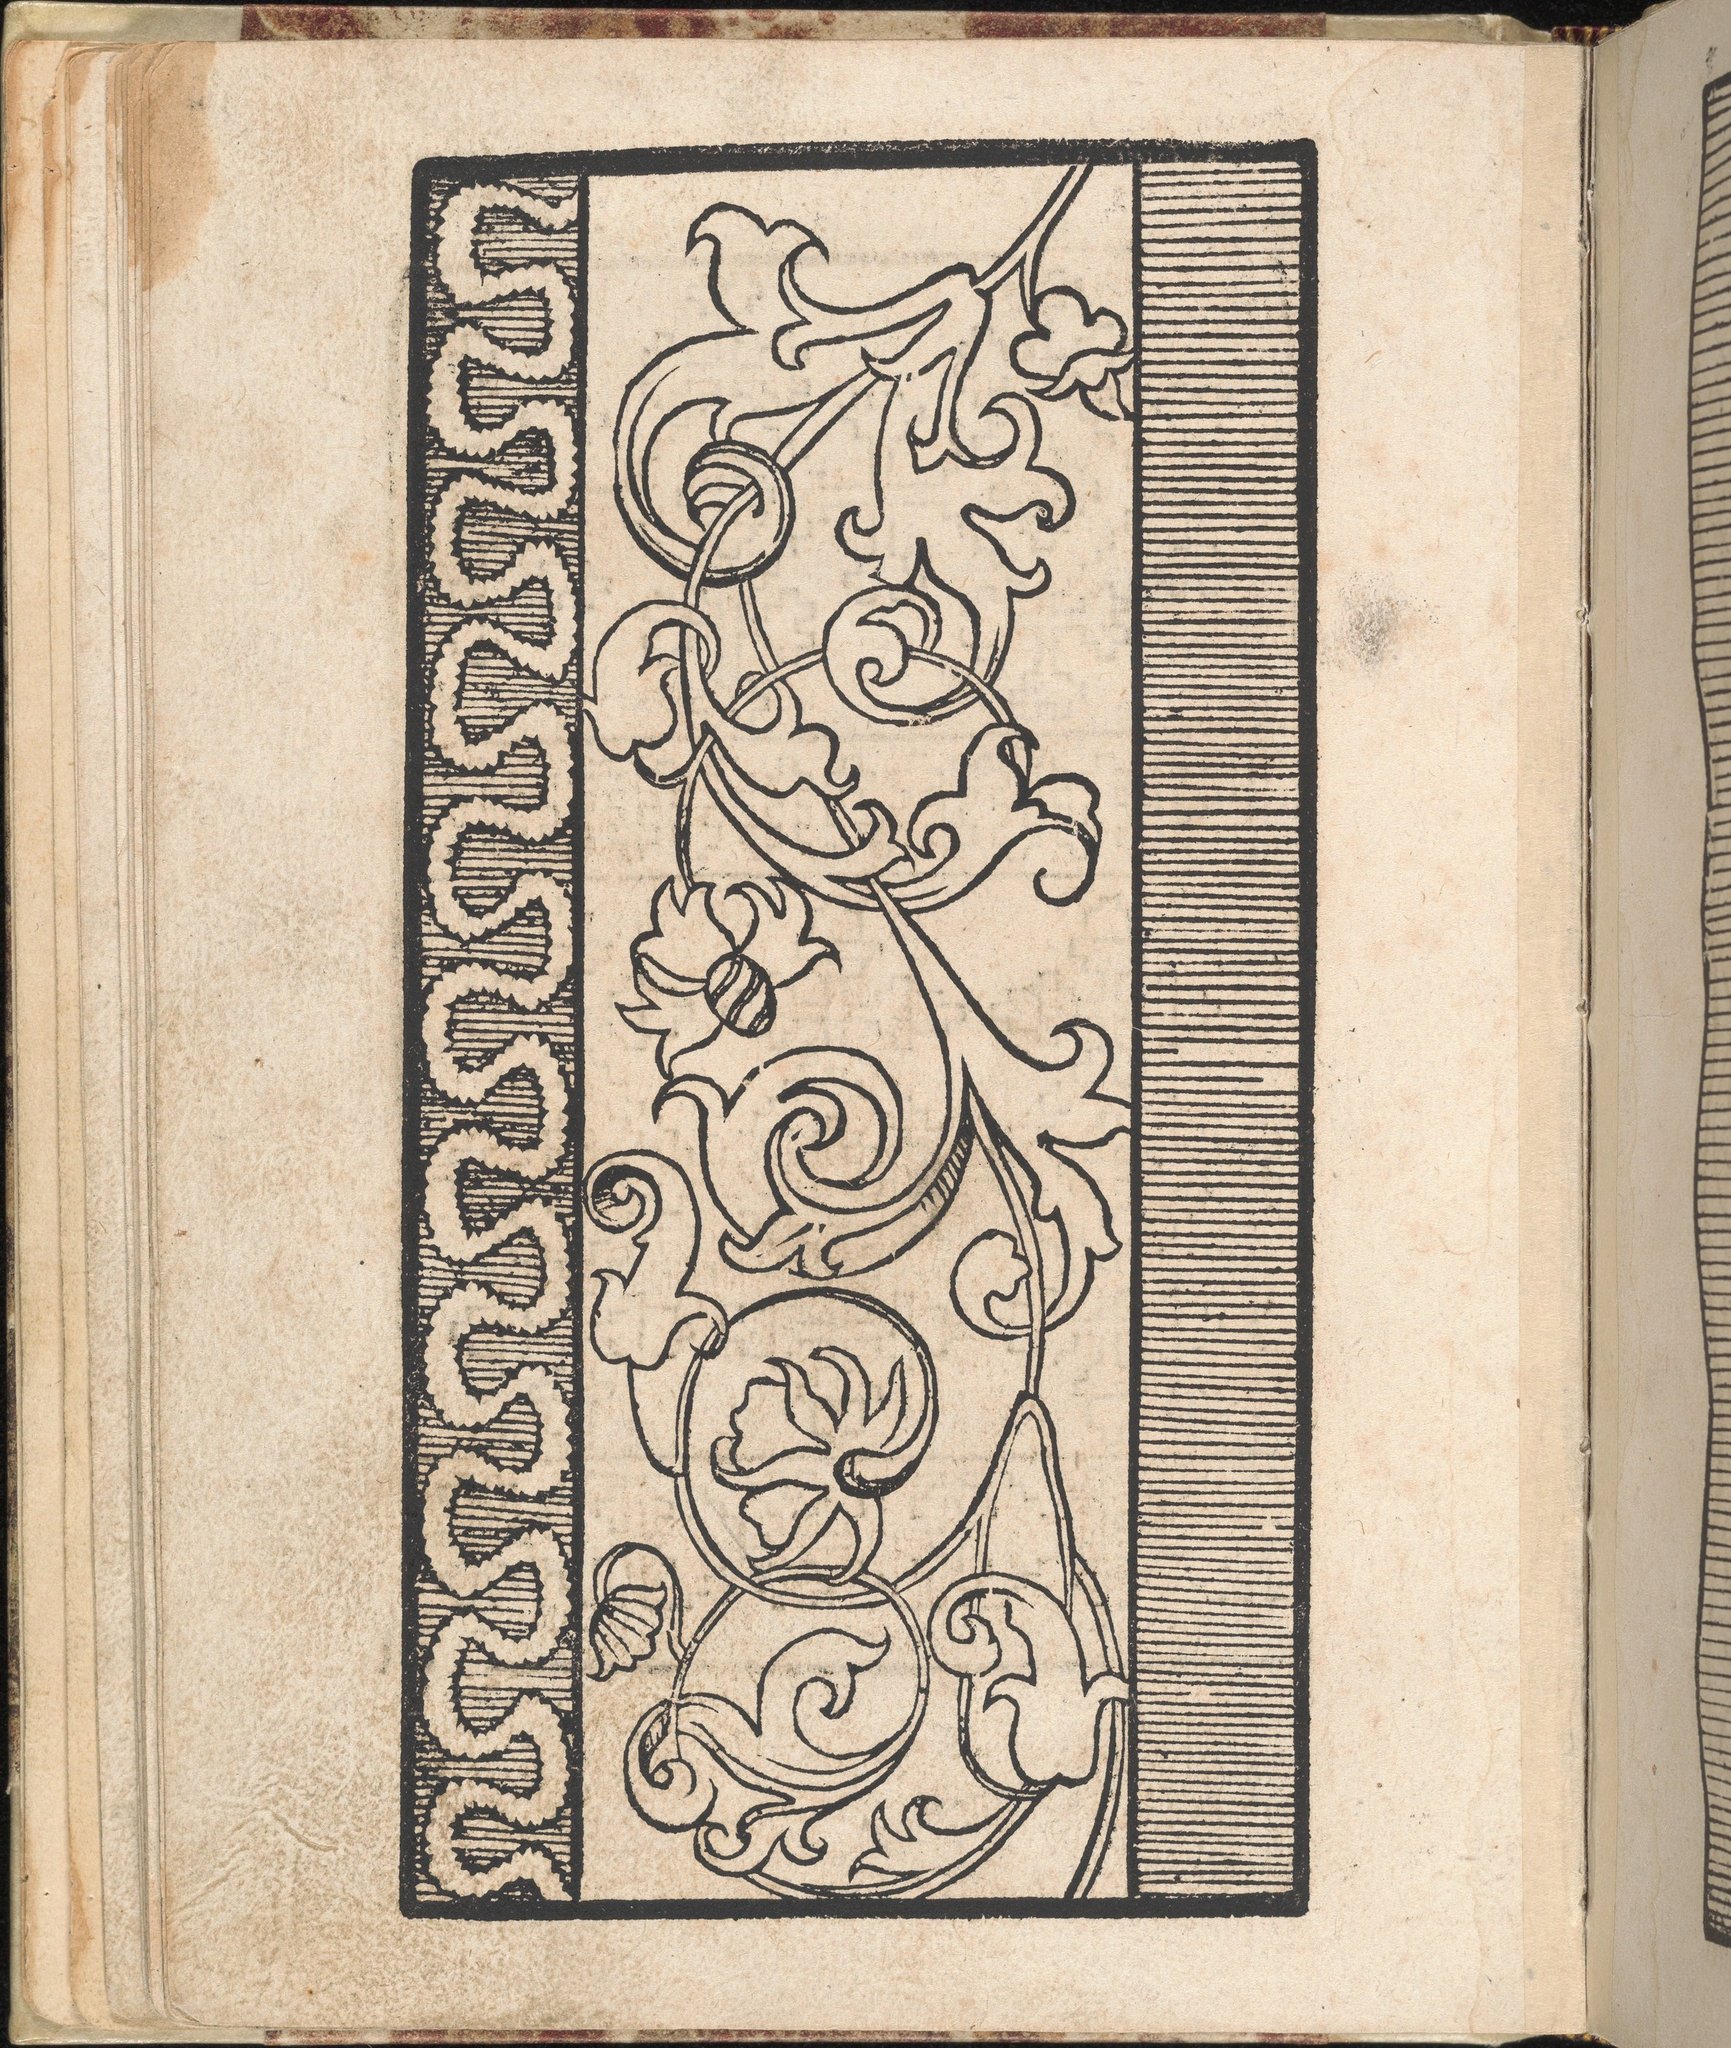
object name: book print ornament architecture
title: Ein new getruckt model Büchli...Page 21, recto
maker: johann schönsperger the younger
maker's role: publisher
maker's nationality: german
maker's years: 1490-1550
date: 1529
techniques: woodcut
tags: ornament